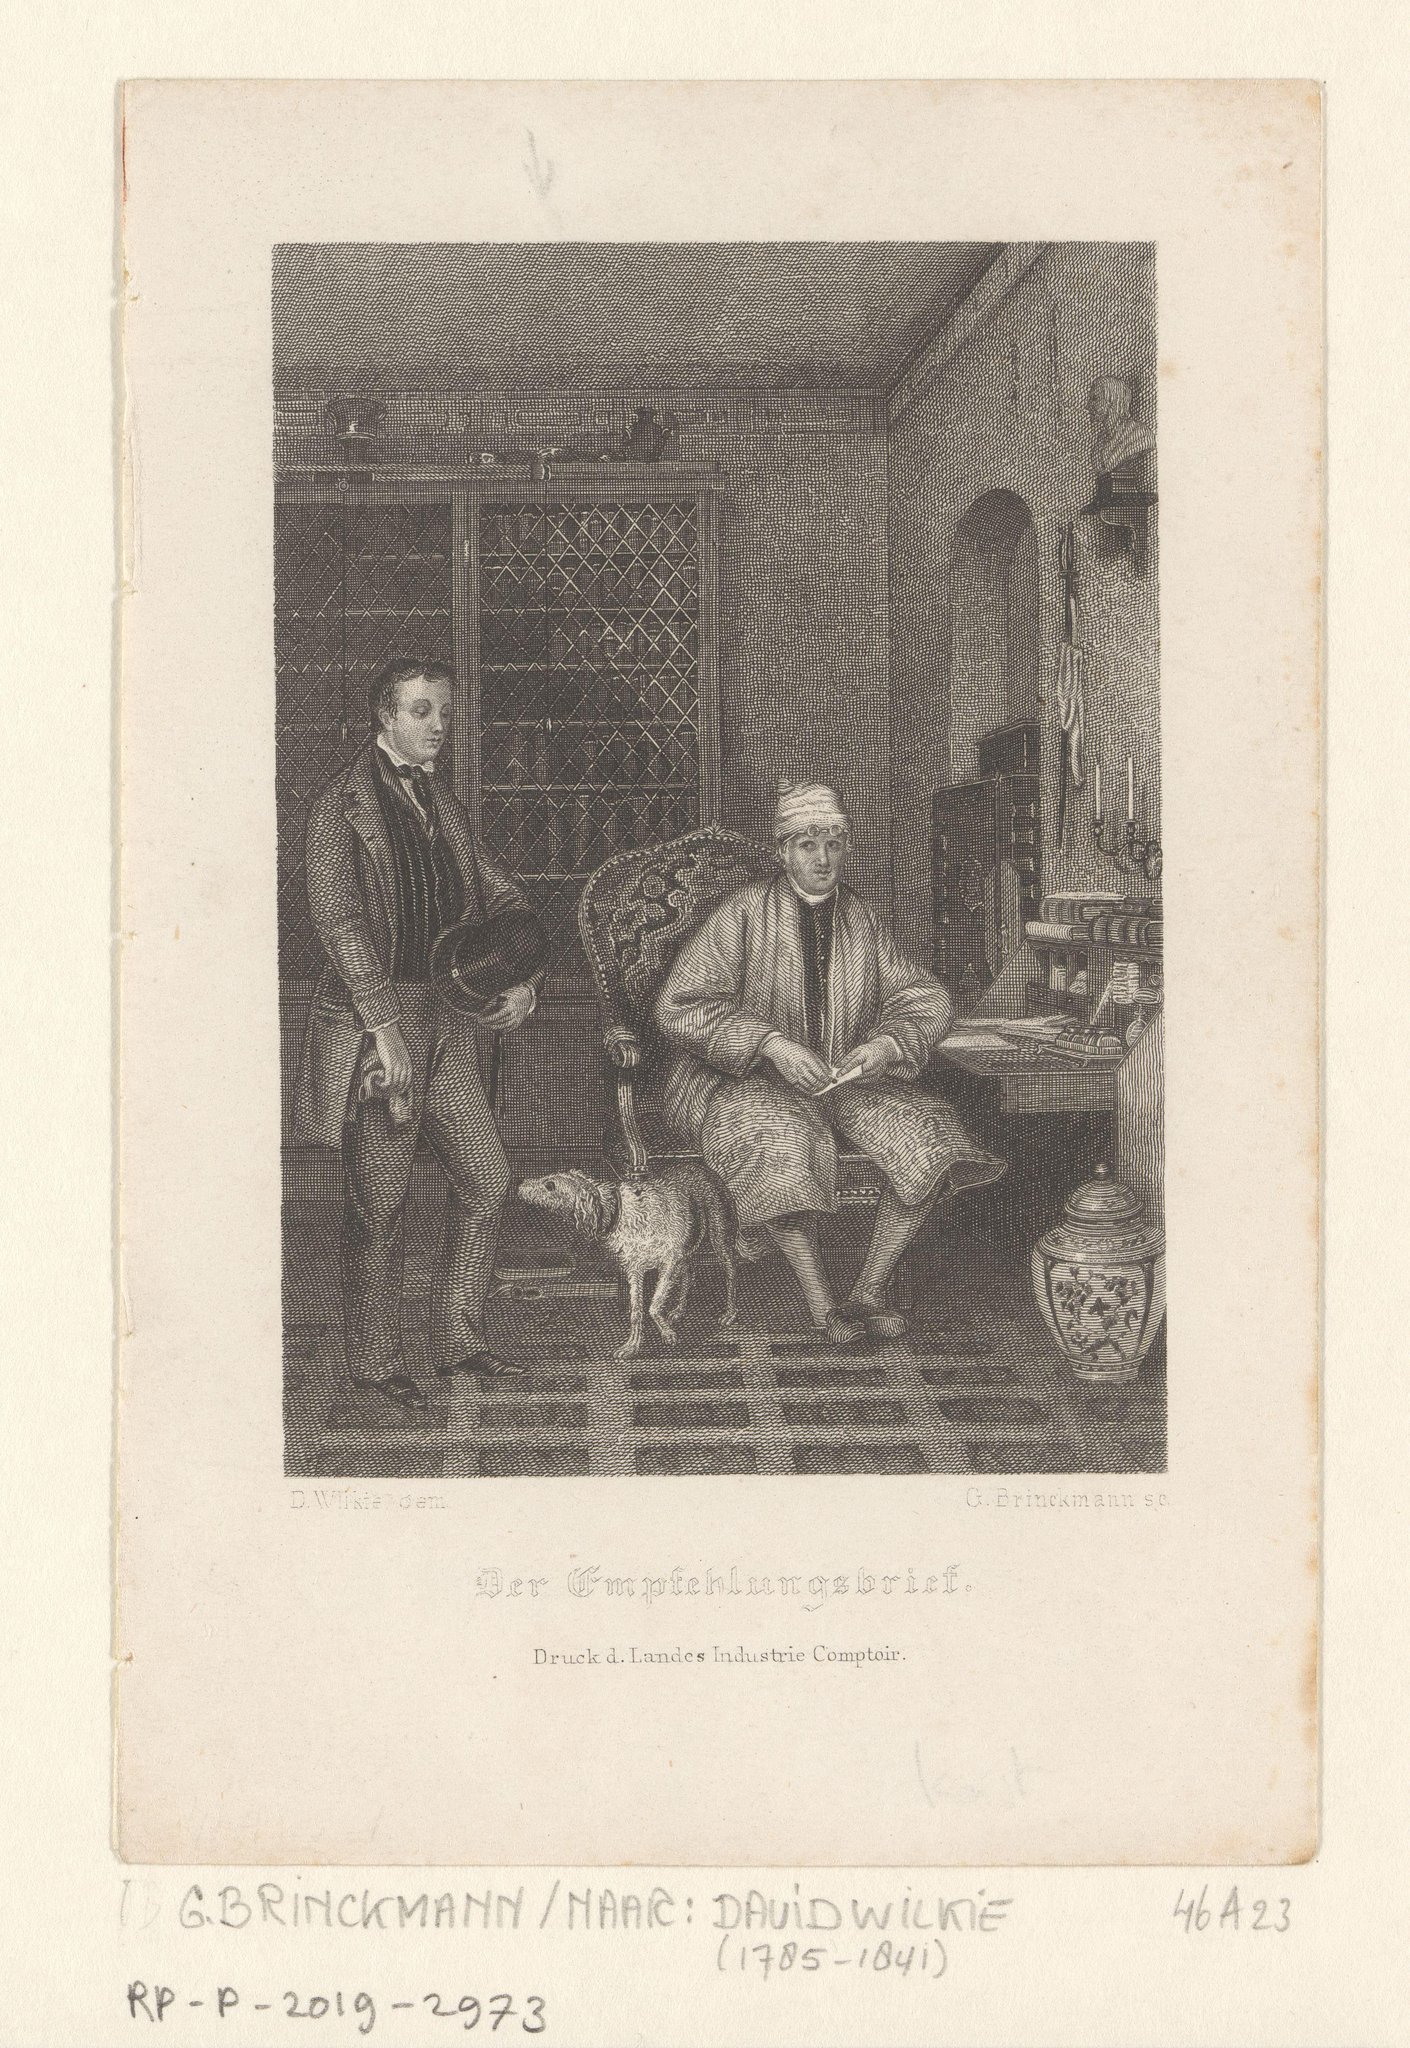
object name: print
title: Man met brief bij een notaris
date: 1800-1899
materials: paper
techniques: etching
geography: germany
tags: contrast between important and unimportant people; the inferior before the superior, the weak before the mighty, notary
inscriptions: collector's mark: Lugt 2228